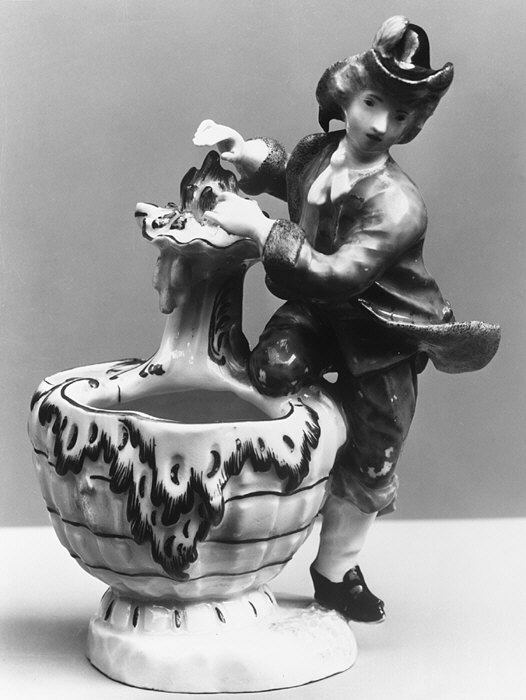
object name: jar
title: Condiment jar (one of a pair), with figure symbolizing Winter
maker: höchst manufactory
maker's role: manufacturer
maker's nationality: german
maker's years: 1746-1796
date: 1750-1755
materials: hard paste porcelain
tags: men